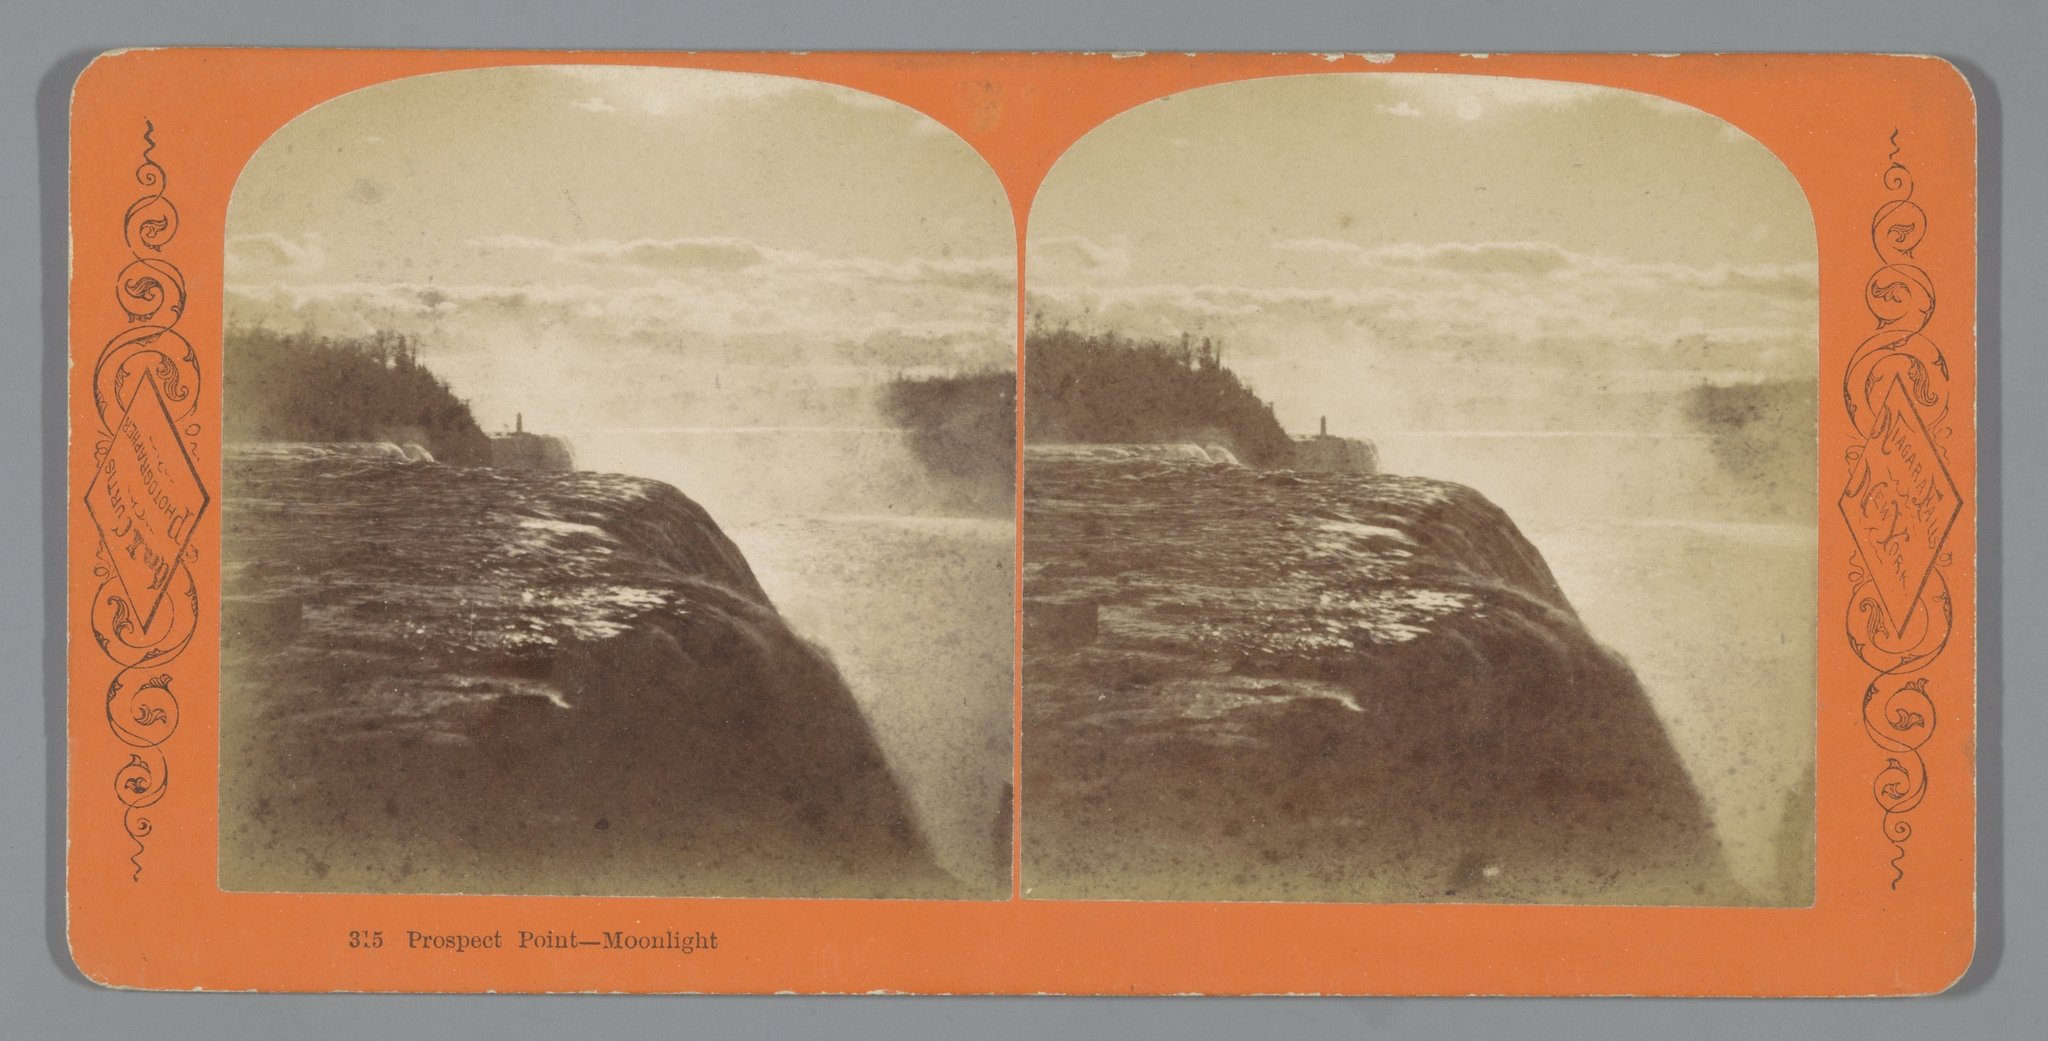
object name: stereograph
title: Gezicht op de Niagarawatervallen en Terrapin Tower bij nacht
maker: george e. curtis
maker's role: fotograaf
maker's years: 1830-1910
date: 1866-1910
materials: cardboard, paper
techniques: albumen print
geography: niagara falls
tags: moonlight, waterfall, night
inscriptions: number: ‘77’, number: ‘315’